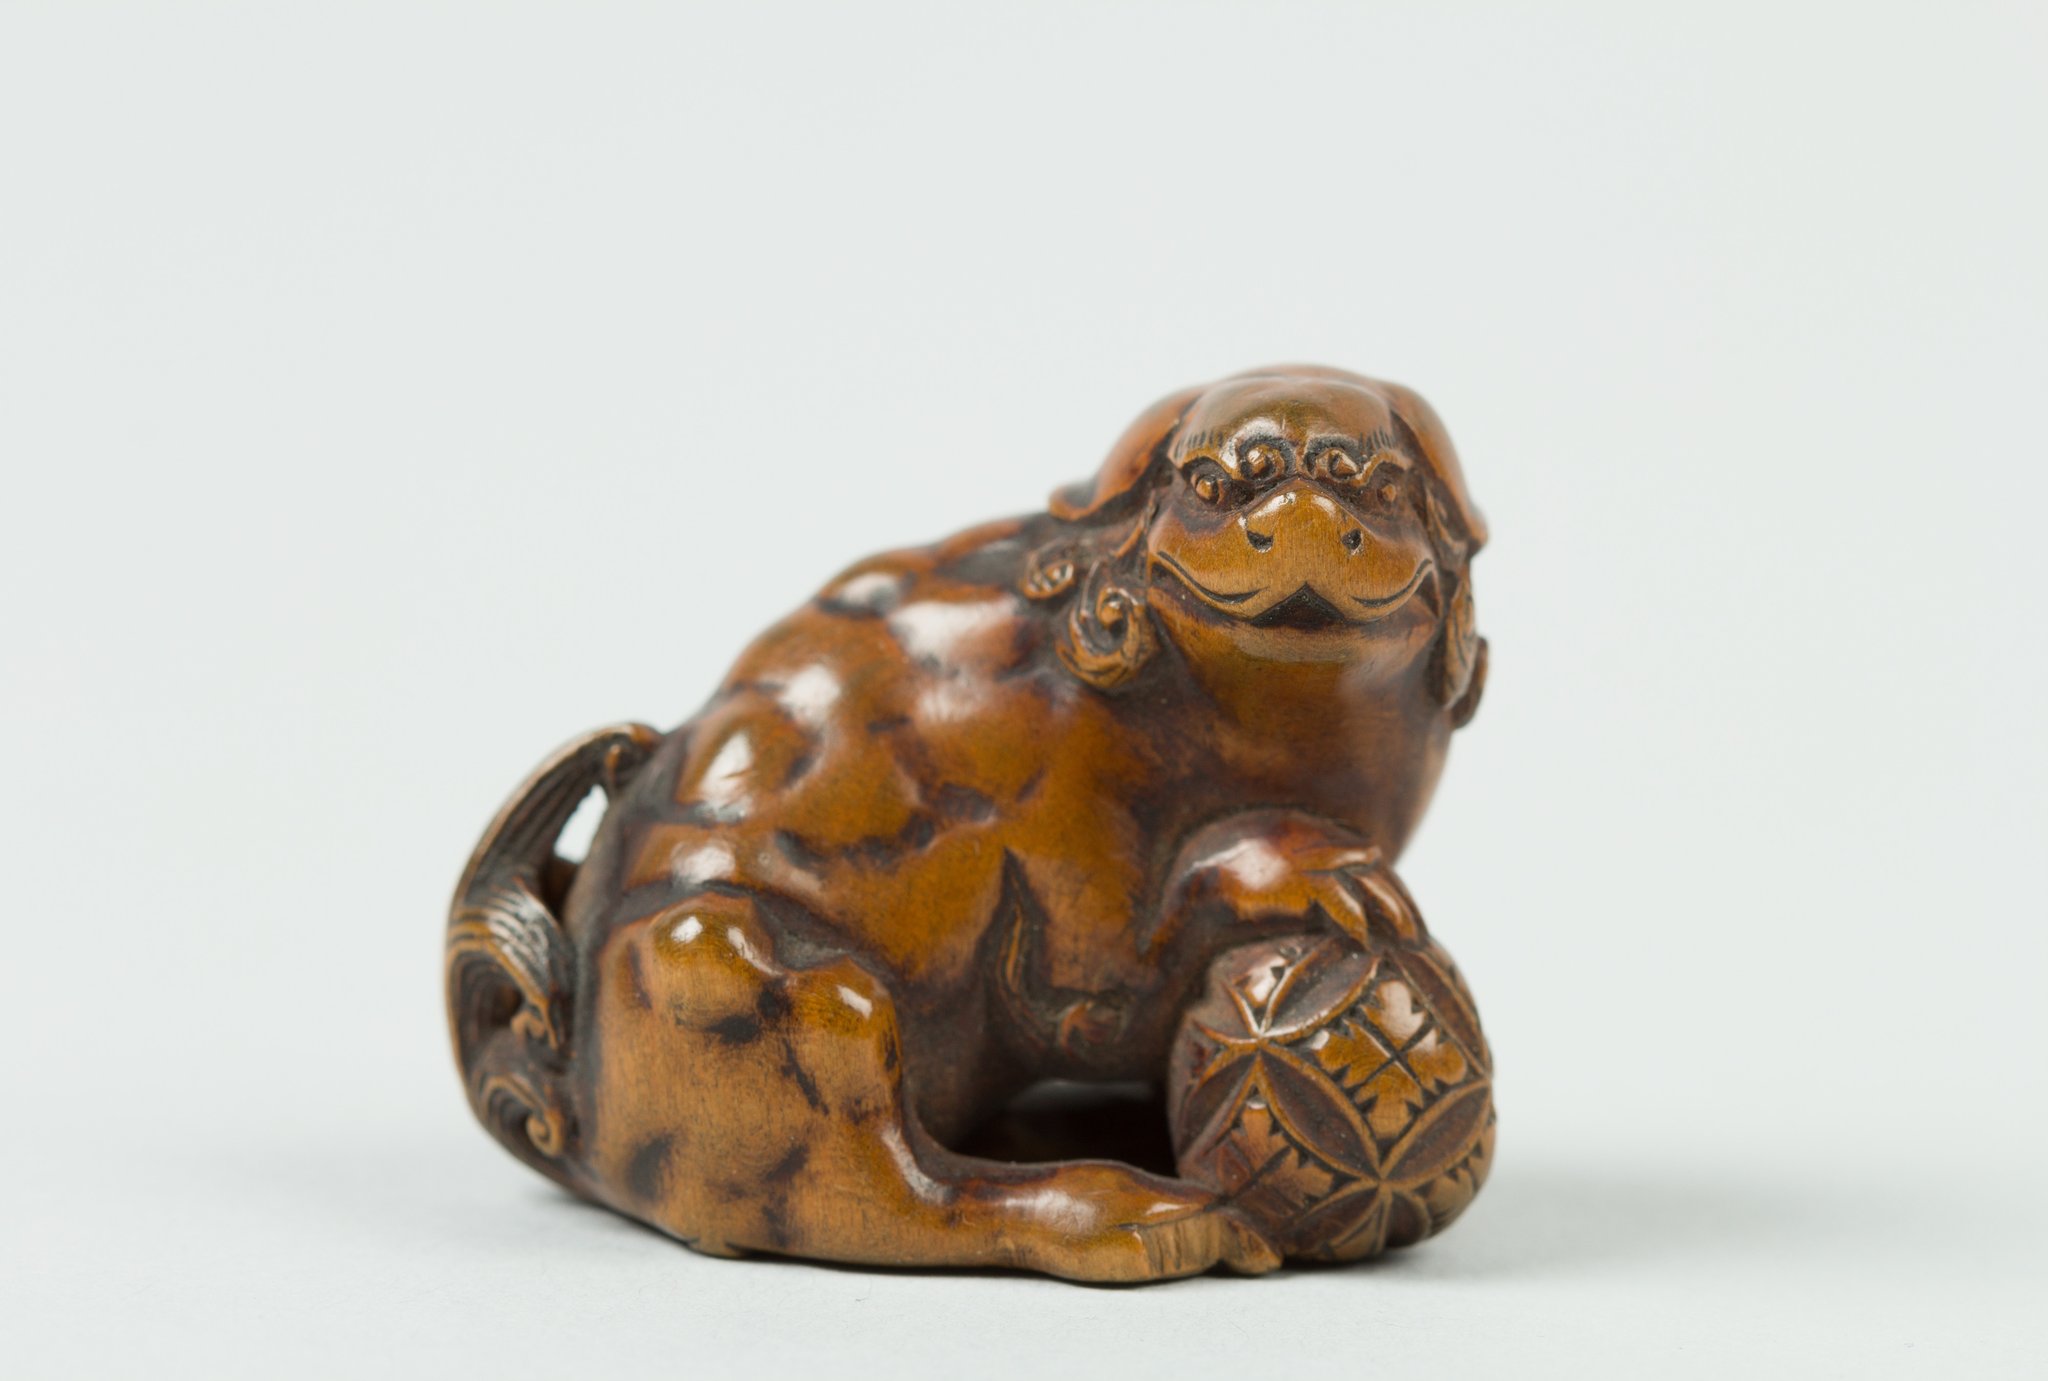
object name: netsuke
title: Netsuke of Qilin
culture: japanese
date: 1801-1900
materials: wood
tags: mythical creatures